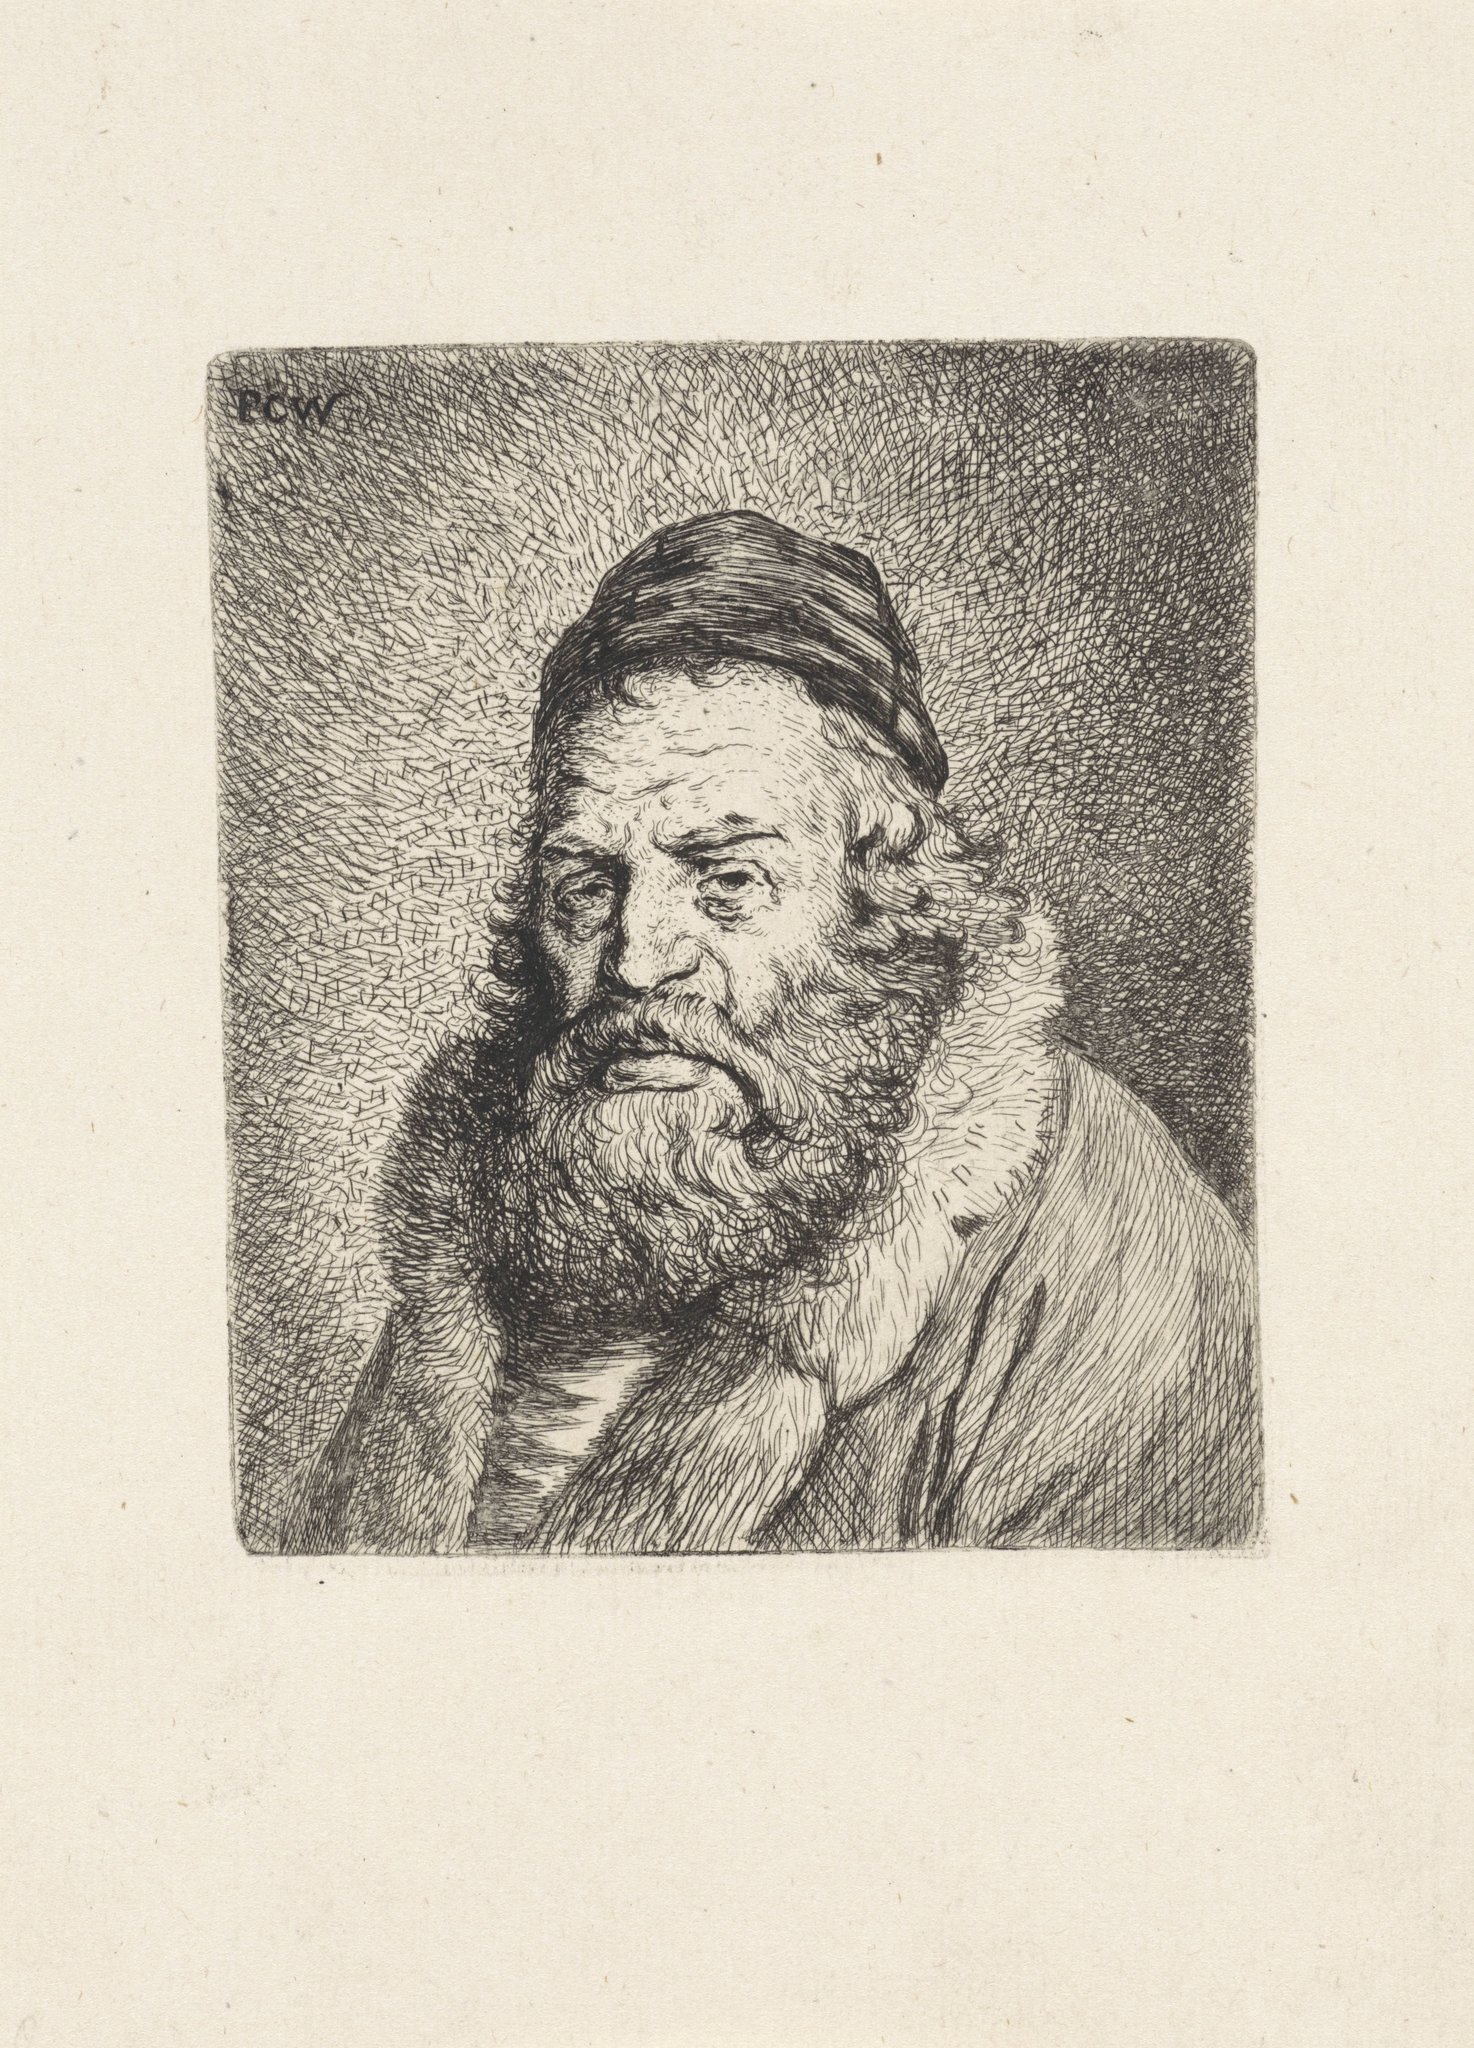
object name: print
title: Portret van Mozes Edrehy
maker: pieter christoffel wonder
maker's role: draughtsman, painter, print maker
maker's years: 1780-1852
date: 1816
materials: paper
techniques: etching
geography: utrecht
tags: historical persons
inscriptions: collector's mark: Lugt 2228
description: Portret van de Joodse theoloog Mozes Edrehy. Hij draagt een muts en een mantel, waarvan de kraag met bont is afgezet.